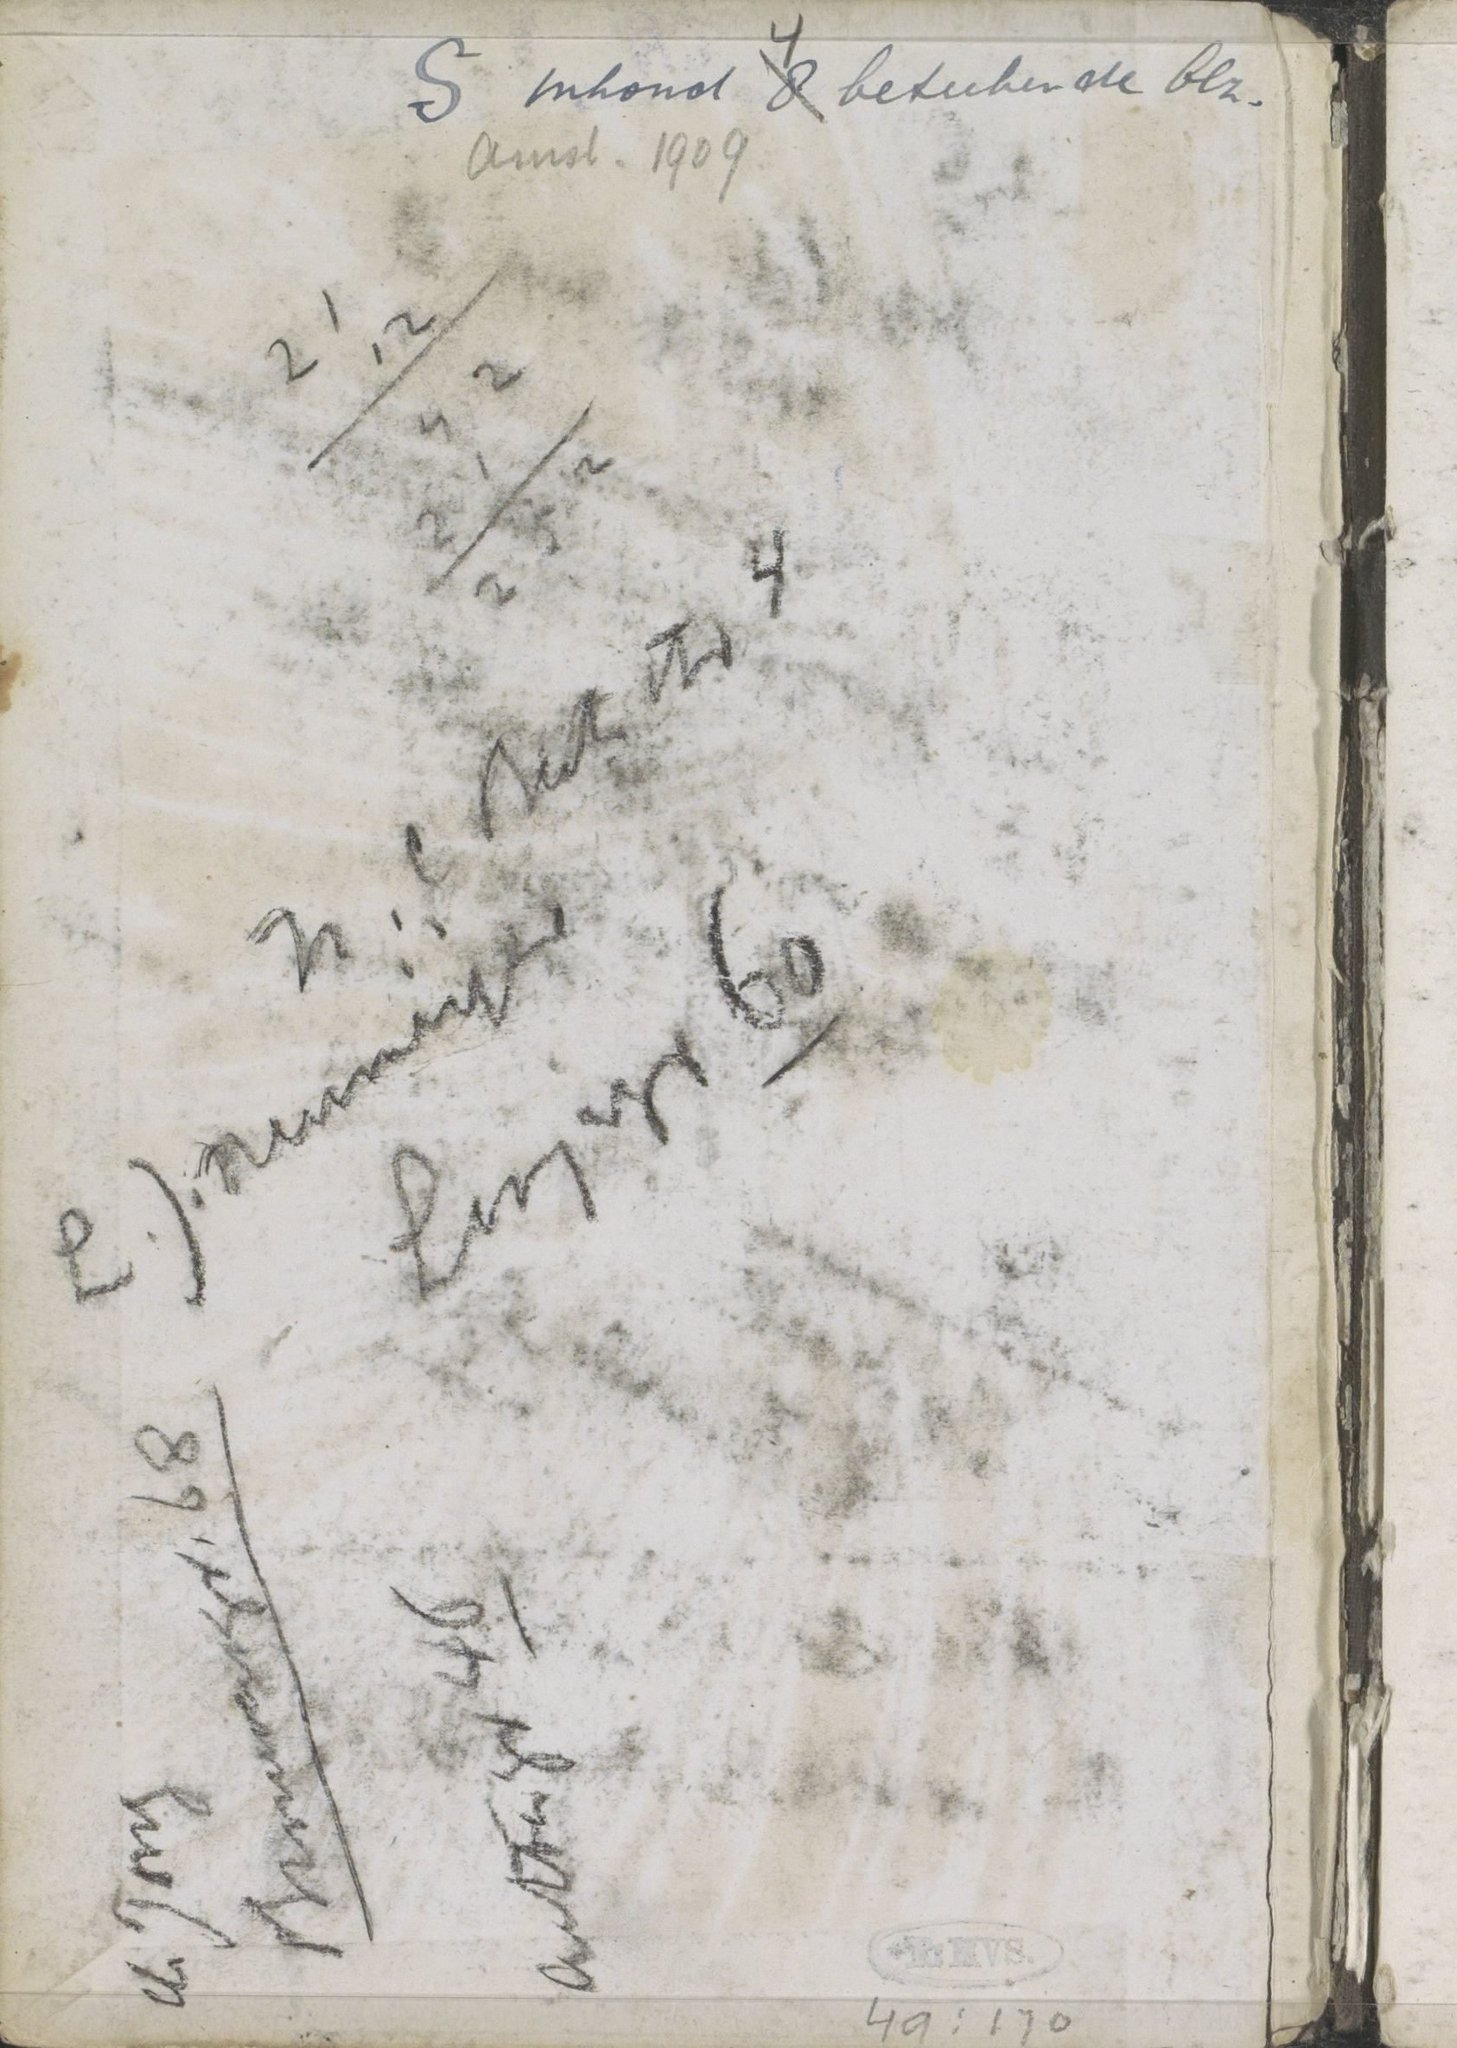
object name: sketchbook leaf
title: Annotaties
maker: george hendrik breitner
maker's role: draughtsman, painter, print maker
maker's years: 1857-1923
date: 1909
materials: chalk, paper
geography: amsterdam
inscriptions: annotation: ‘[...]/ N.C. Beetsstr. 4/ L.J. Neumeijer/ Looiersgr 60/ de Jong/ Brouwersgr. 68/ Achtergr. 46’, collector's mark: Lugt 2228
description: Pagina 1, voorste schutblad, uit een schetsboek met 8 bladen.